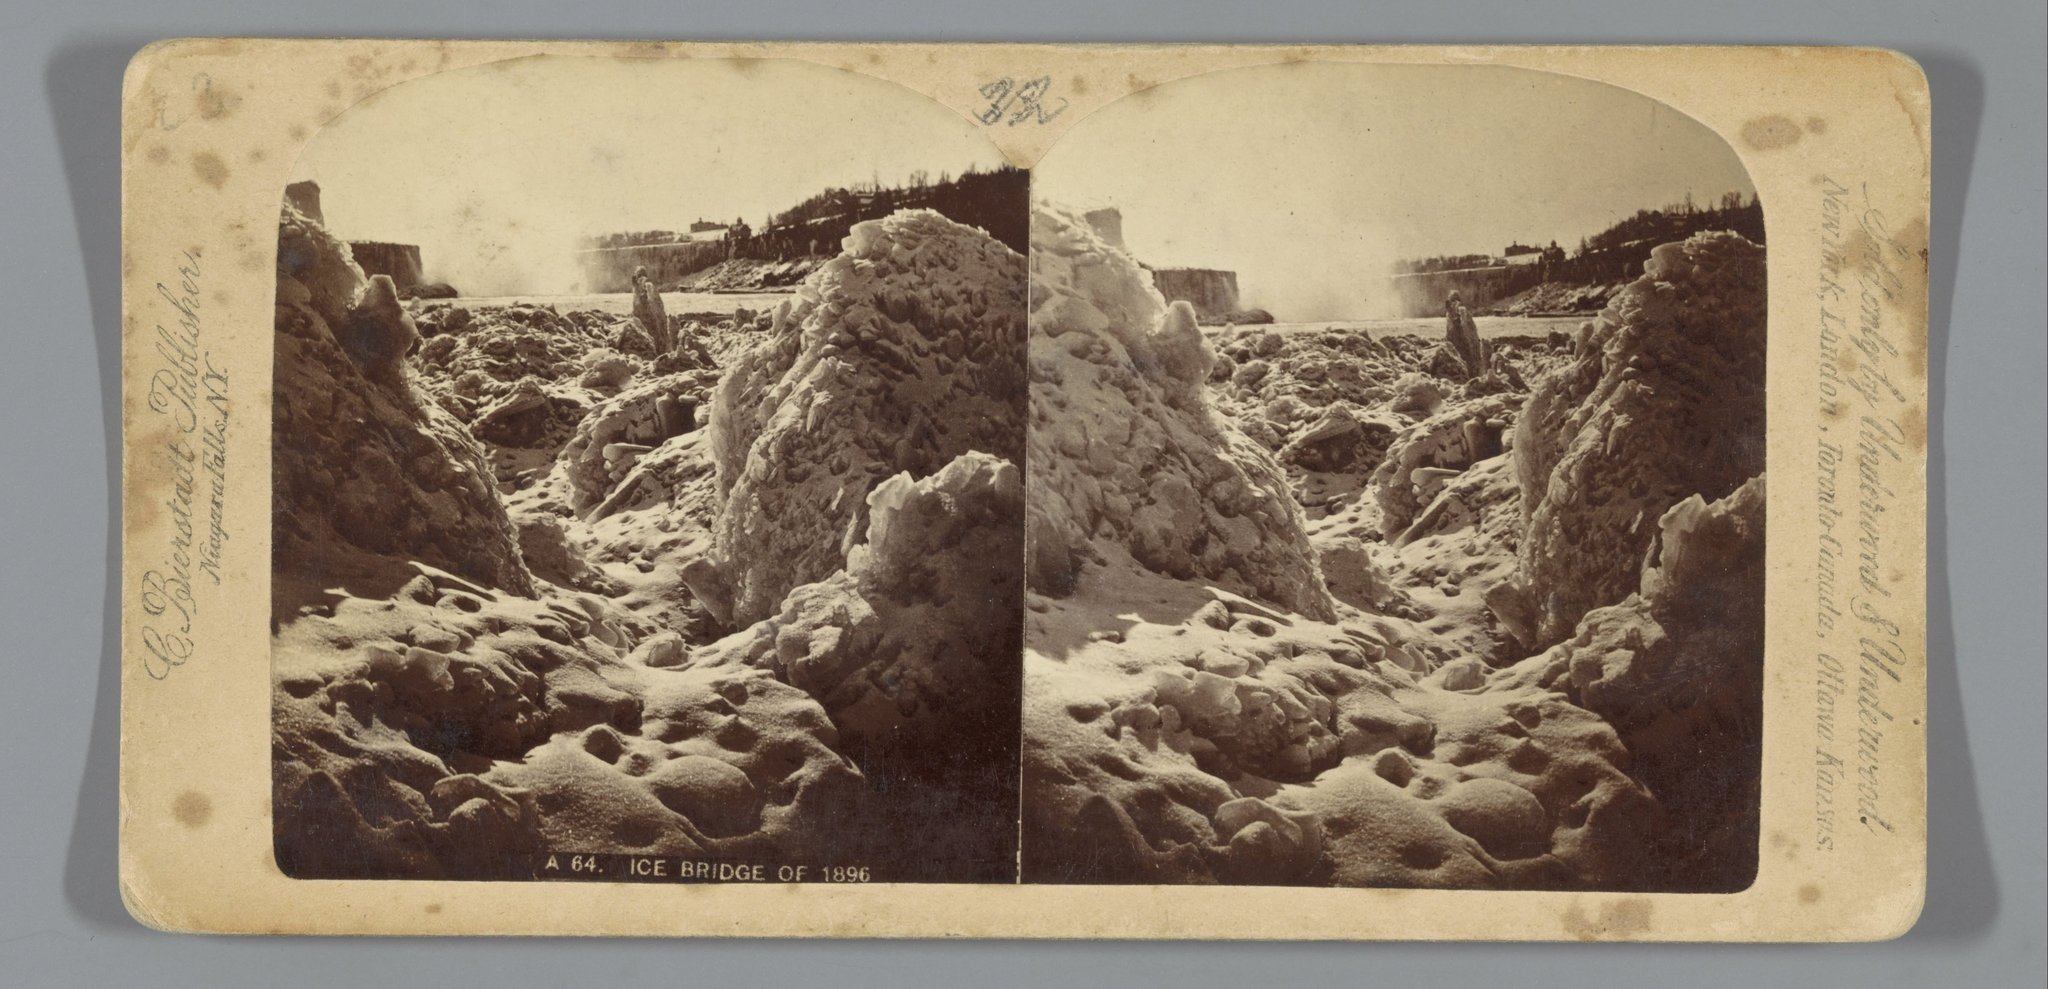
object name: stereograph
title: Ice Bridge of 1896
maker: charles bierstadt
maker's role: publisher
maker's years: 1819-1903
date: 1896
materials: cardboard, paper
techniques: albumen print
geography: new york city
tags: waterfall, ice ~ state of water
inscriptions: number: ‘32’, title: ‘Ice Bridge, Niagara Falls, U. S. A.’, number: ‘A 64.’